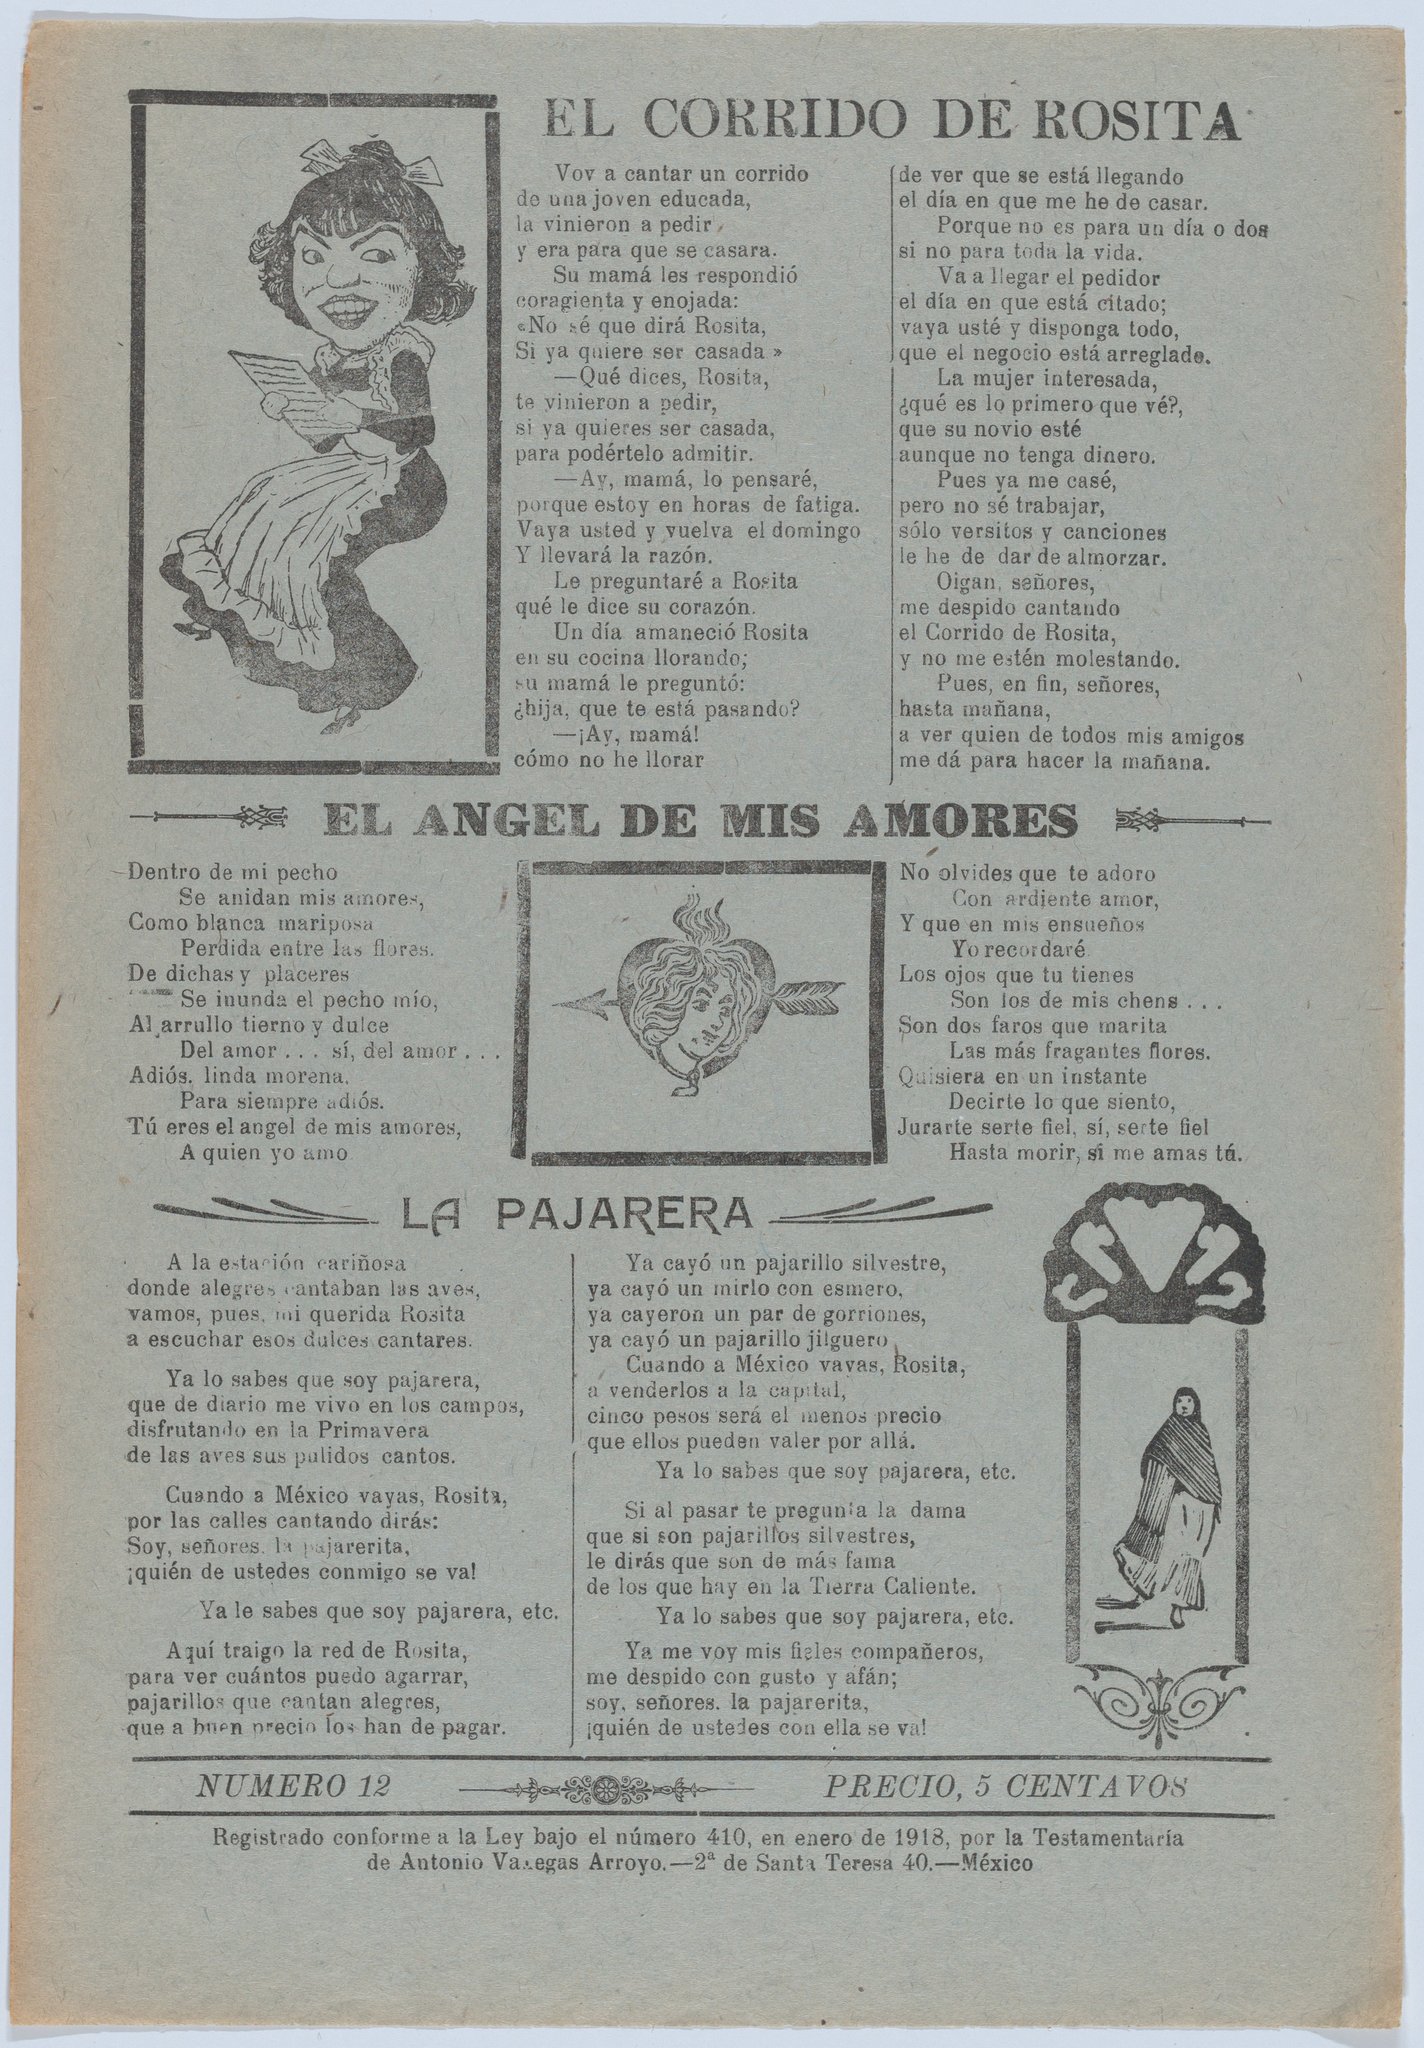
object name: print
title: Broadsheet featuring three love ballads with vignettes showing a woman reading, a woman's head in a heart pierced by an arrow and a woman walking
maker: josé guadalupe posada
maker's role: artist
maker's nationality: mexican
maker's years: 1852-1913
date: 1918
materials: paper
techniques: letterpress, lithography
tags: arrows,women,reading,walking